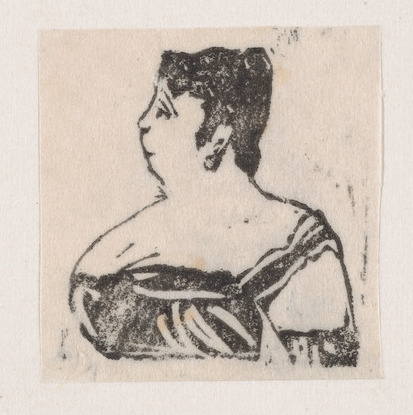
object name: print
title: Profile of a woman wearing an evening gown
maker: josé guadalupe posada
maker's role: artist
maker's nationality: mexican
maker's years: 1852-1913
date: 1880-1910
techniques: woodcut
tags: profiles,women